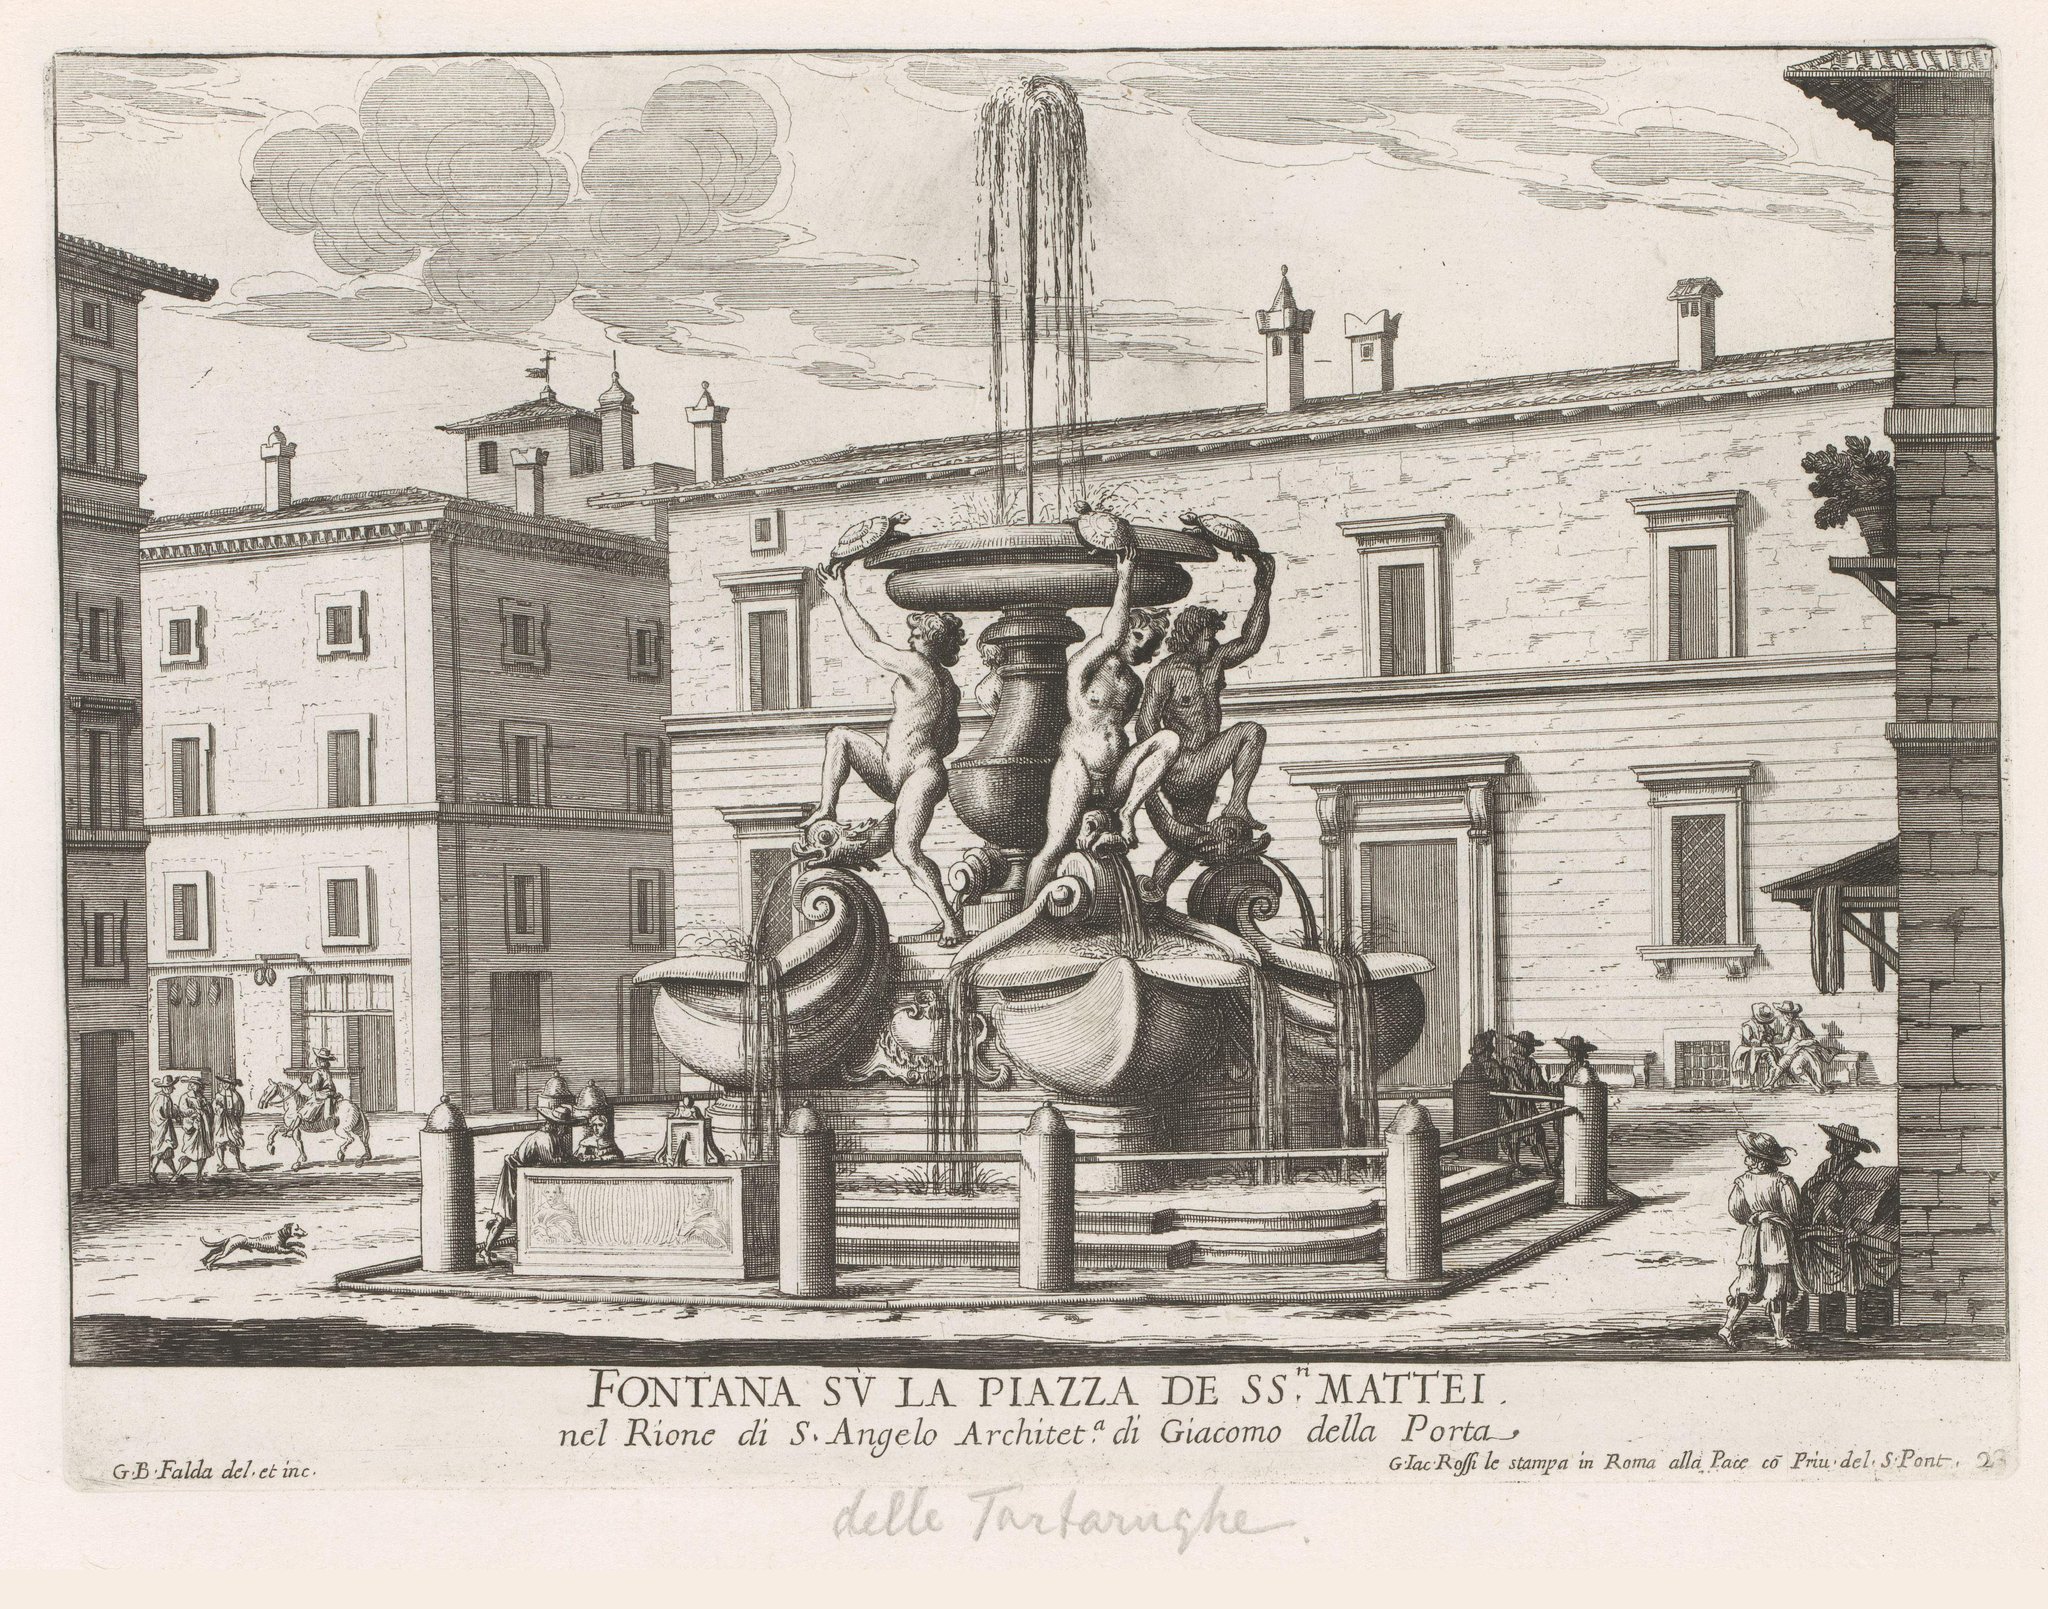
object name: album leaf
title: Fontane di Roma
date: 1653-1691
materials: paper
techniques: etching, intaglio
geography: italy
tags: tortoises, turtles, ornamental fountain, rome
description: Genummerd rechtsonder: 23. De prent maakt deel uit van een album.